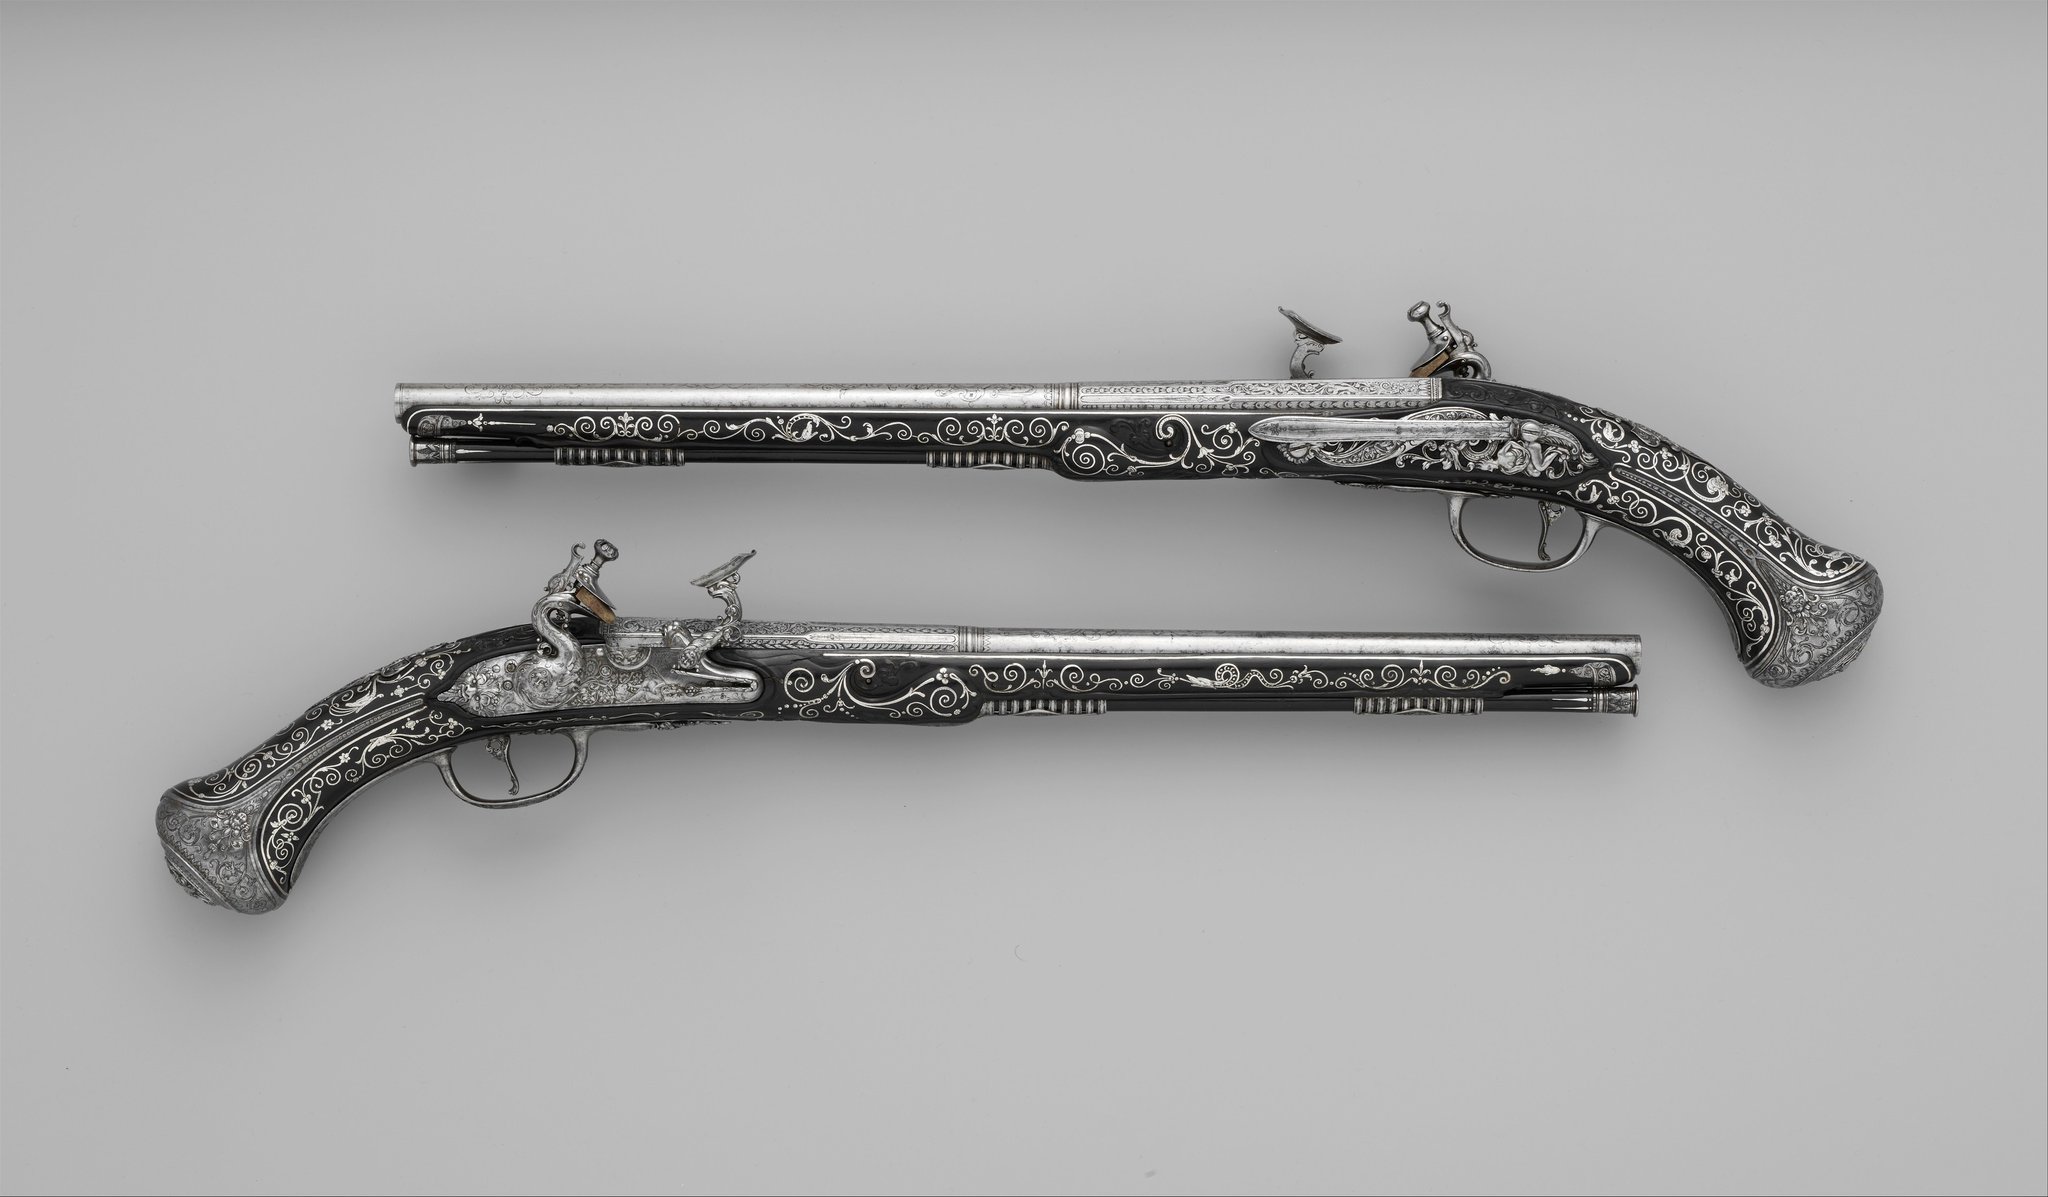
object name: pair of pistol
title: Pair of Snaphaunce Pistols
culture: italian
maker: matteo cecchi, called acquafresca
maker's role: gunsmith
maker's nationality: italian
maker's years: 1651-1738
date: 1690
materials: silver, steel, wood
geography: italy